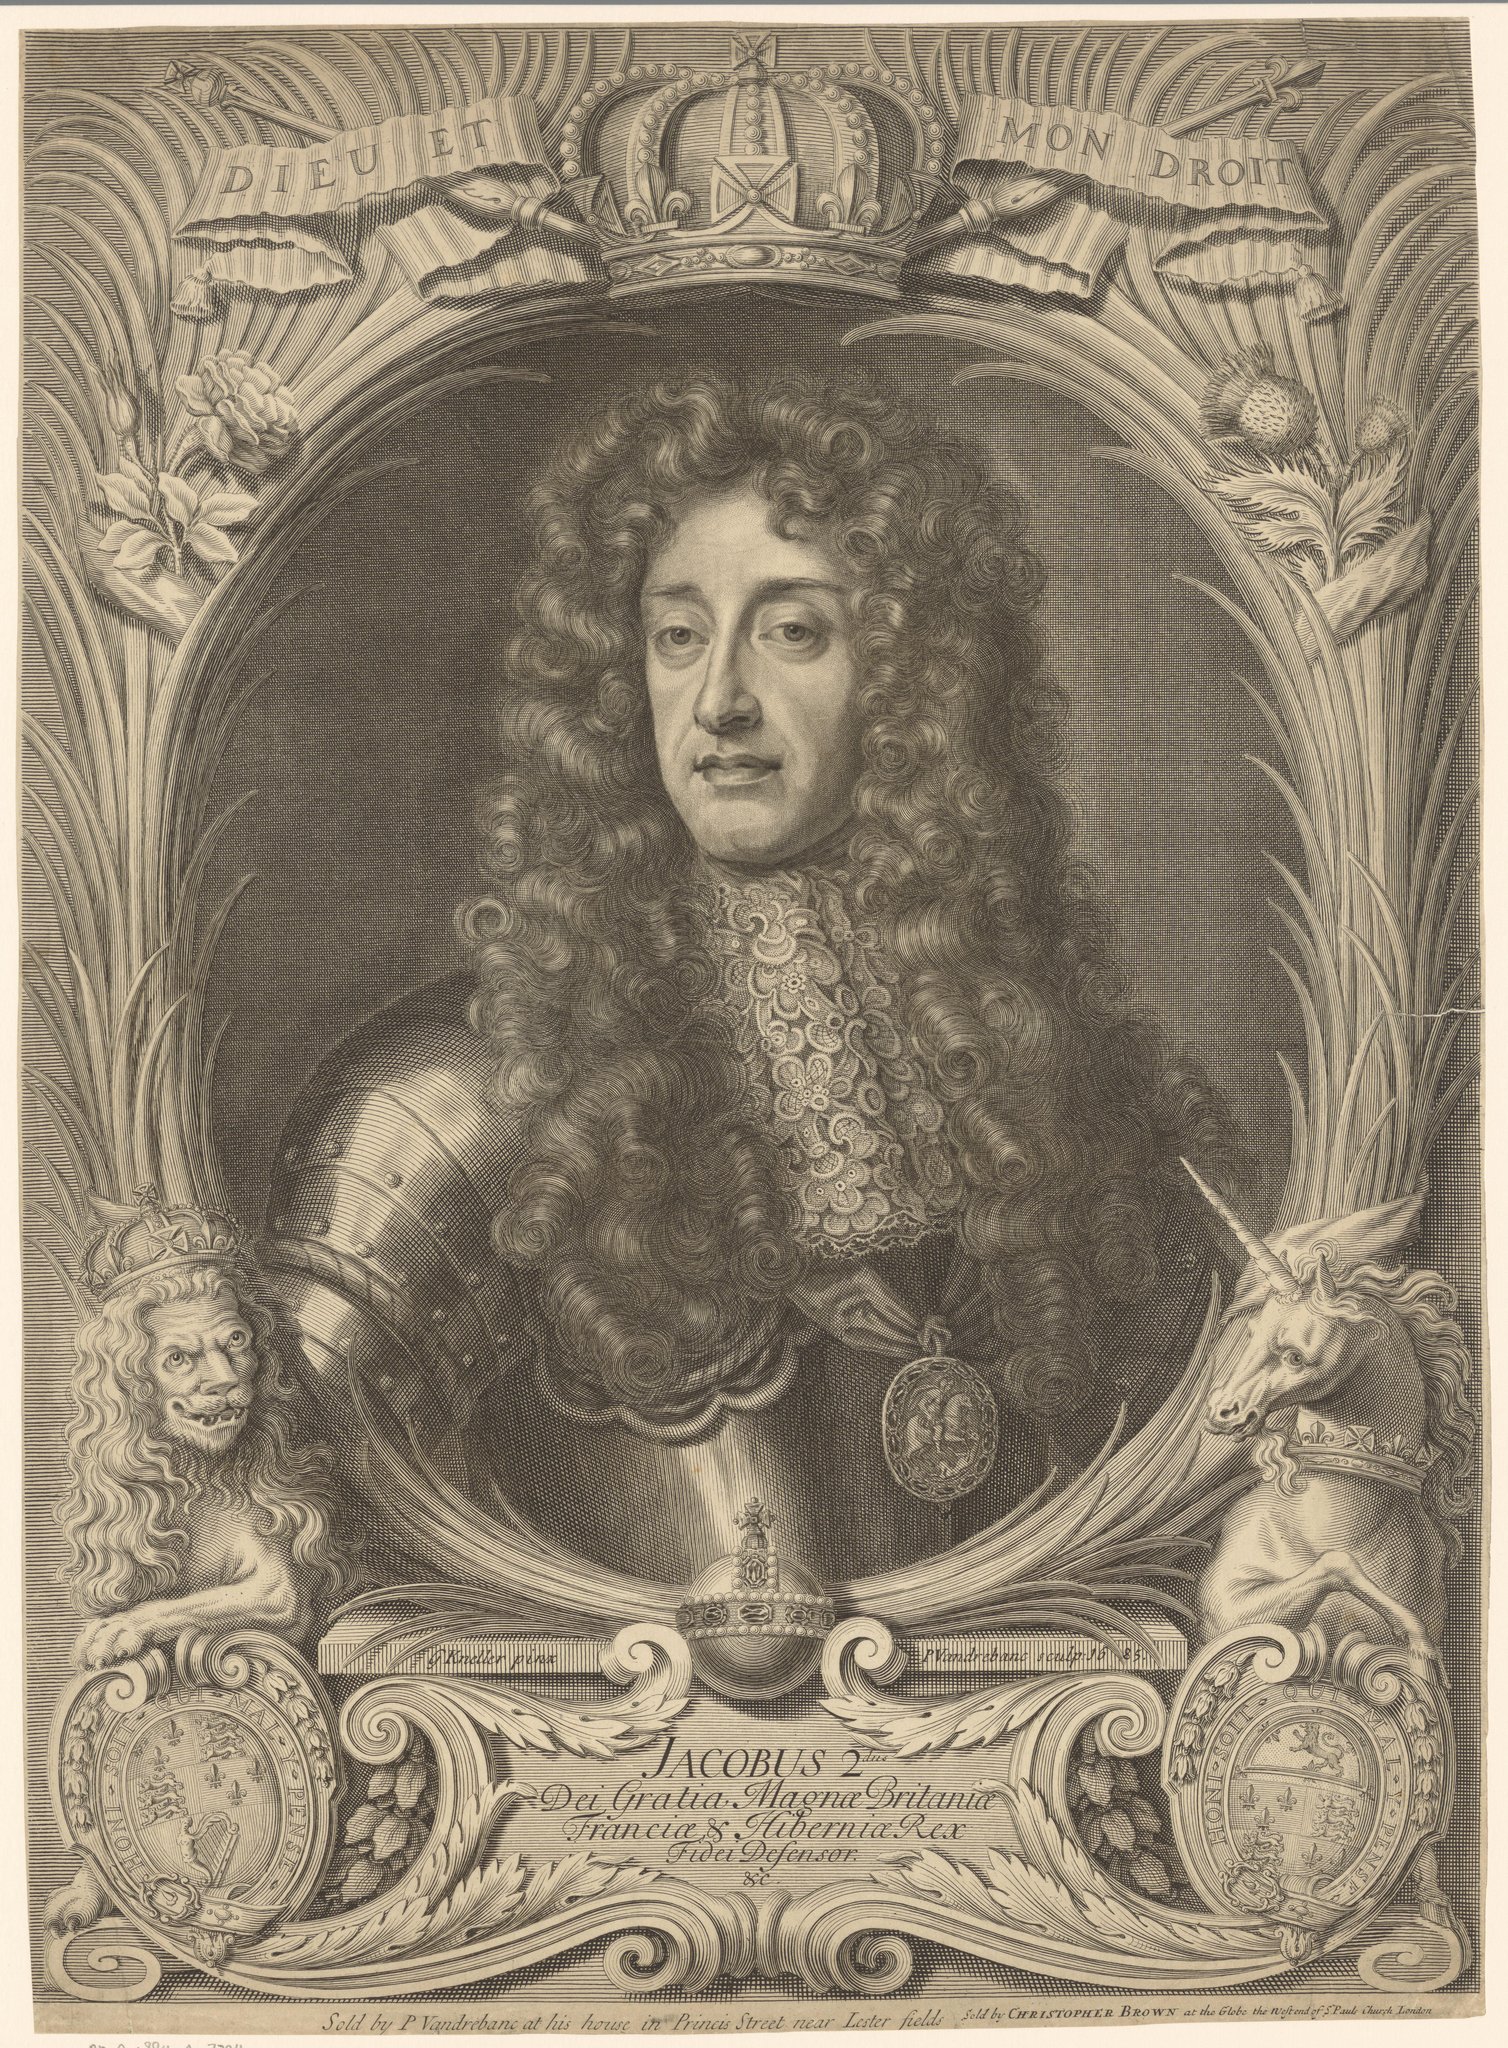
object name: print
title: Portret van Jacobus II, koning van Engeland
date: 1685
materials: paper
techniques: engraving, etching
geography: london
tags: jacobus ii (koning van engeland en schotland), unicorn, coat of arms (as symbol of the state, etc.) (+ nation; national), historical persons, king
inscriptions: collector's mark: Lugt 2228